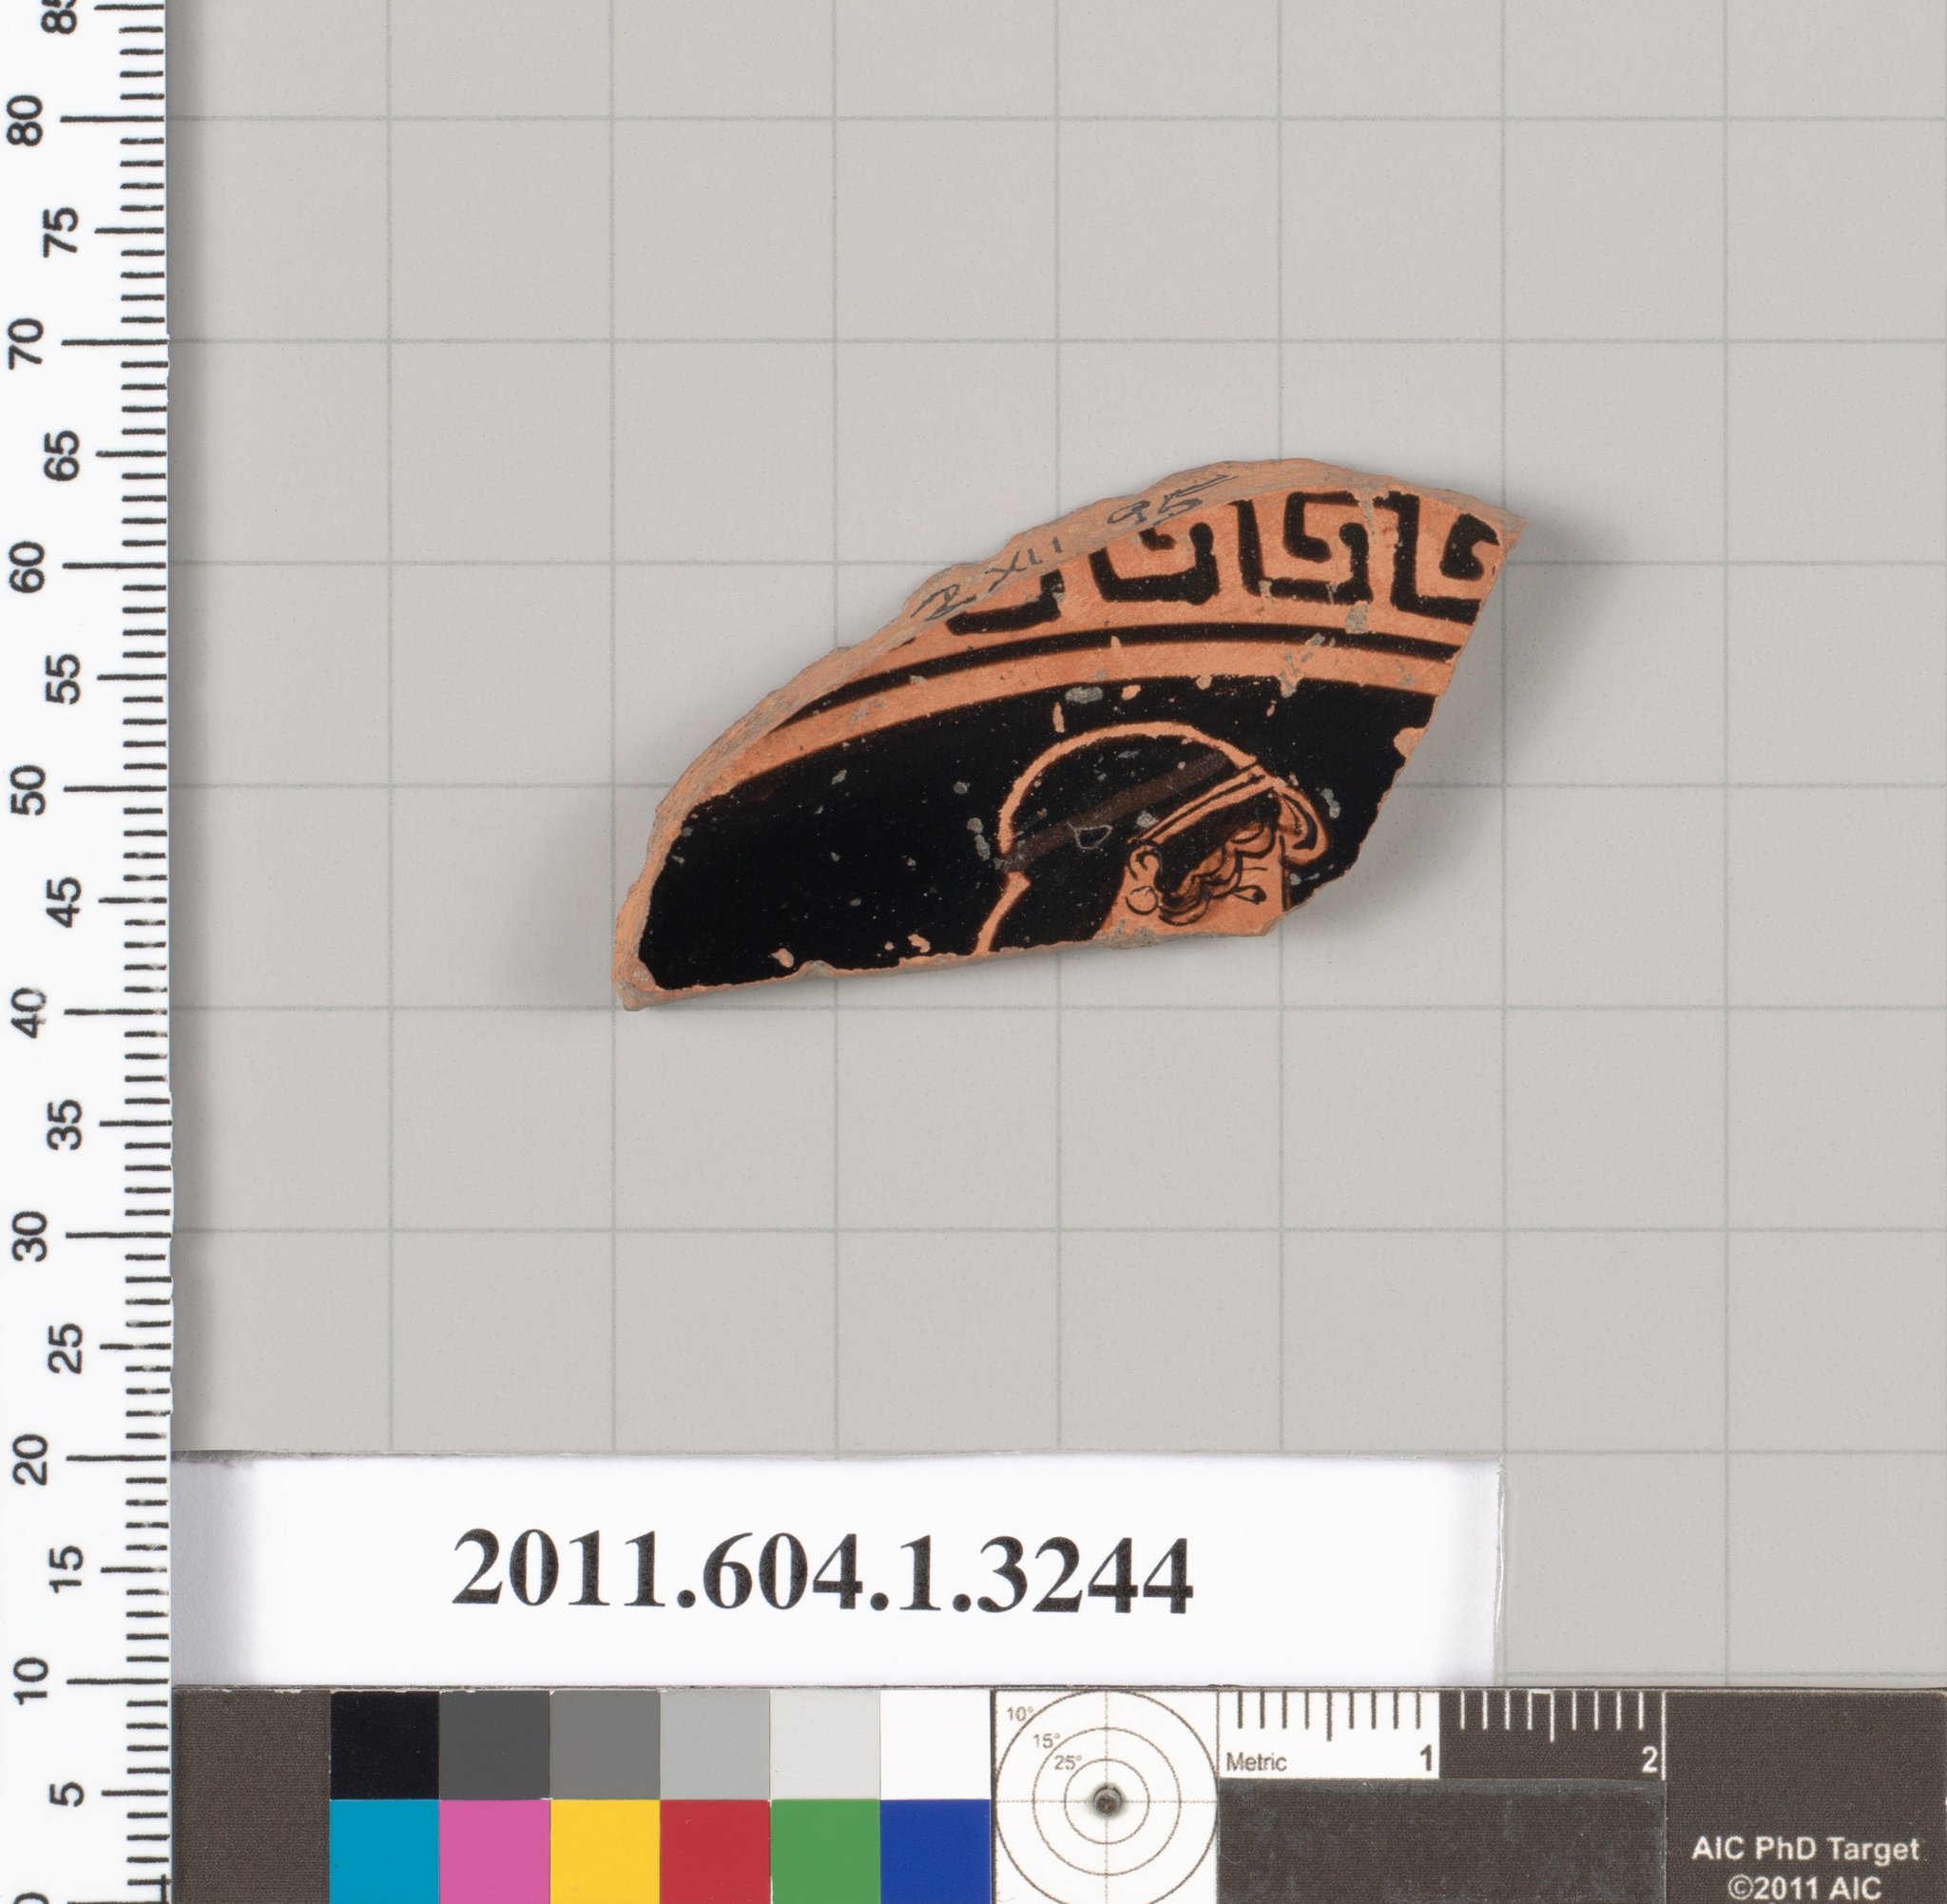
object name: kylix fragment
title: Terracotta fragment of a kylix (drinking cup)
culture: greek, attic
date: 500-451 BCE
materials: terracotta